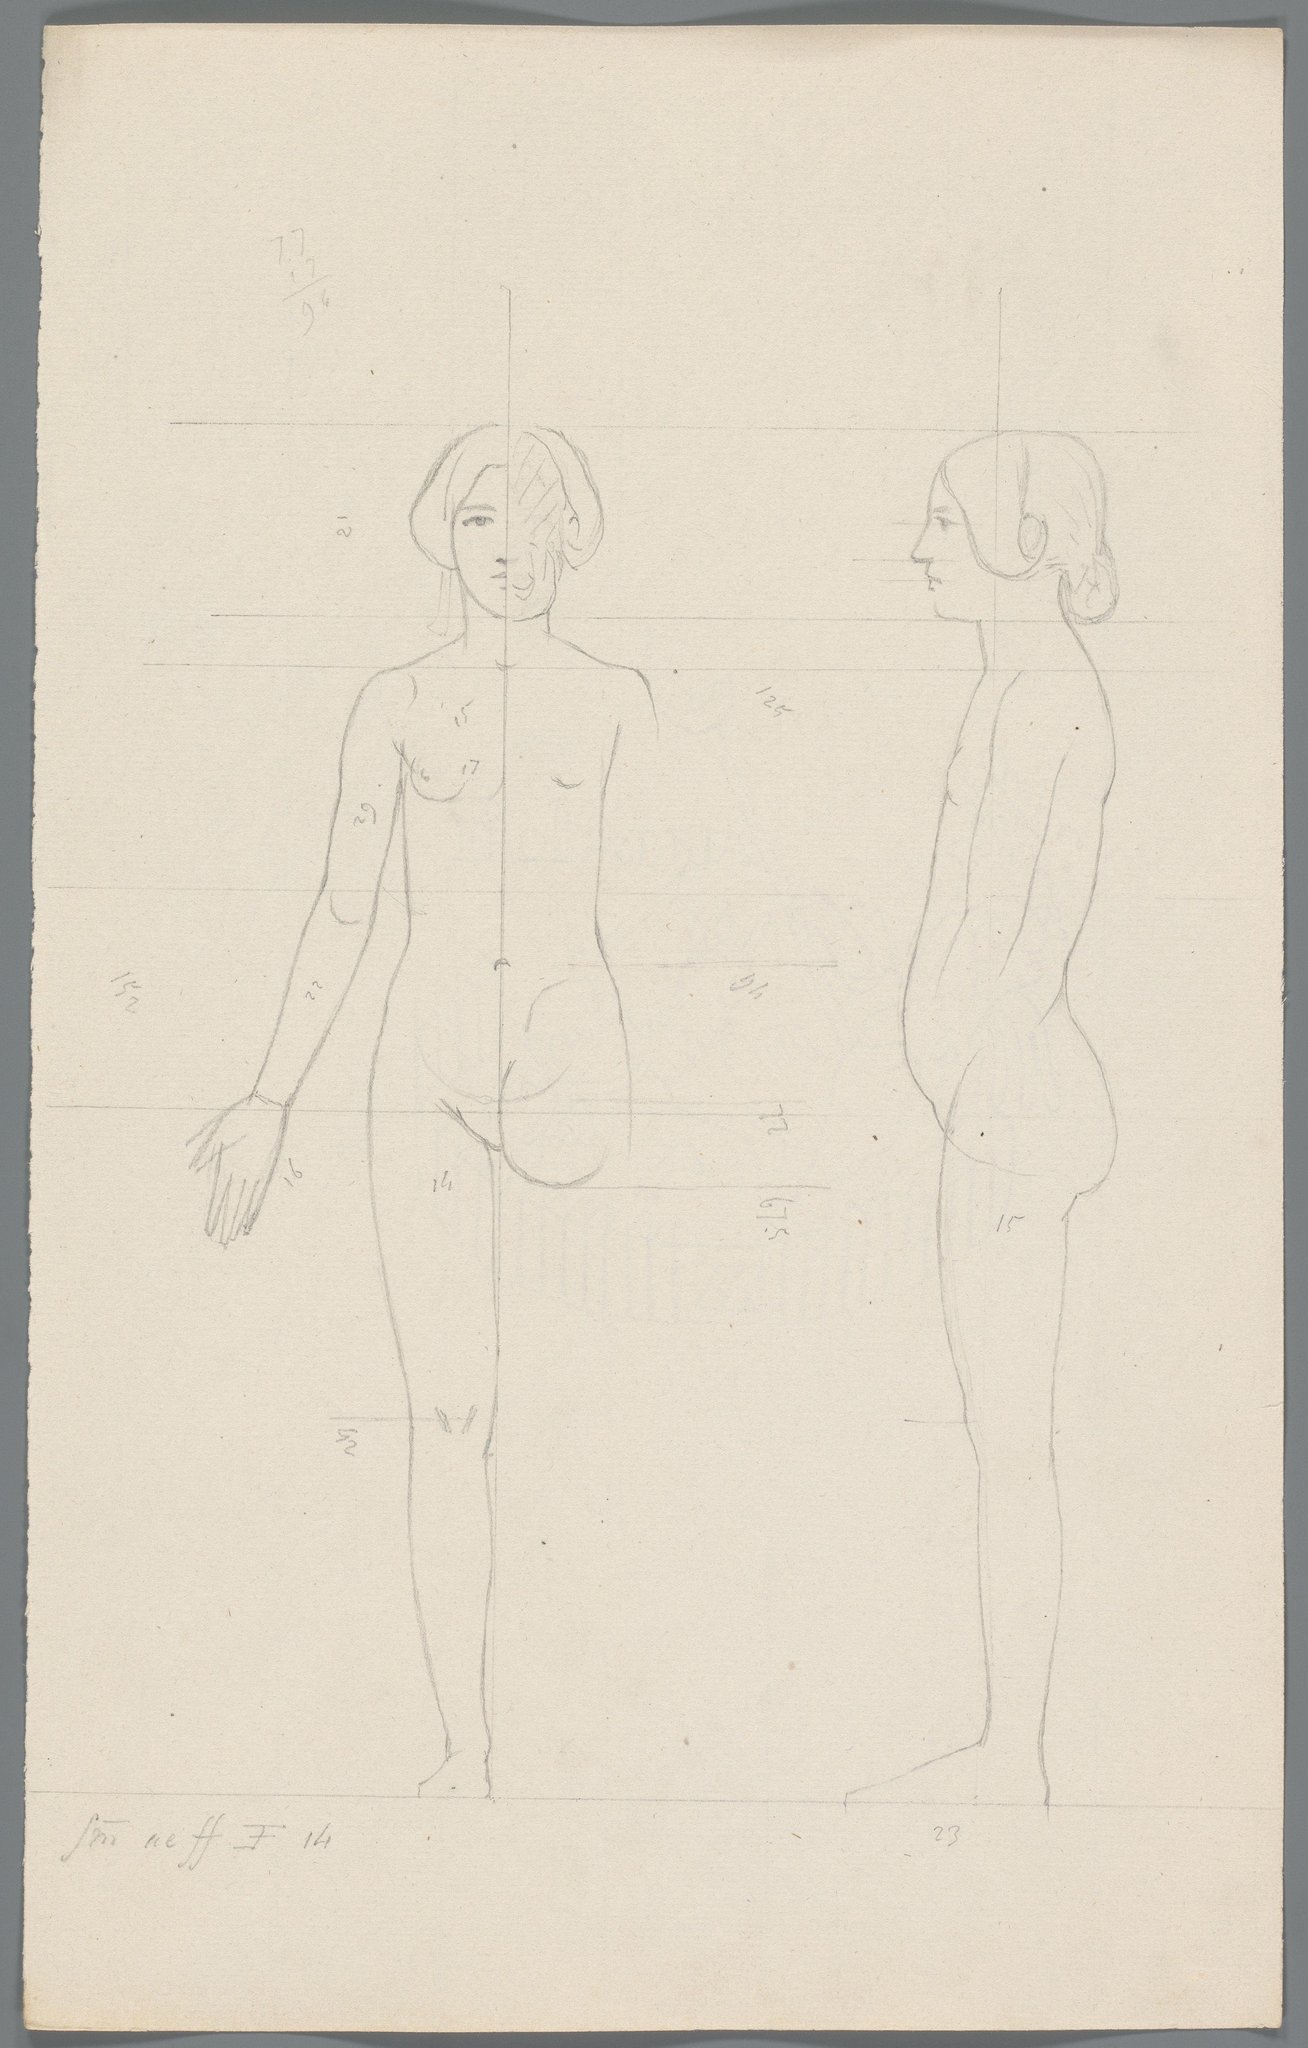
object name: drawing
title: Proportiestudie van een vrouw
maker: jacobus everhardus josephus van den berg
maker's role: draughtsman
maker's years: 1802-1861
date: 1856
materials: paper, pencil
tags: standing figure (canon, proportions) - aa - female human figure, anatomy (non-medical) - aa - female human figure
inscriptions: inscription: ‘sm ae ff EF 14’